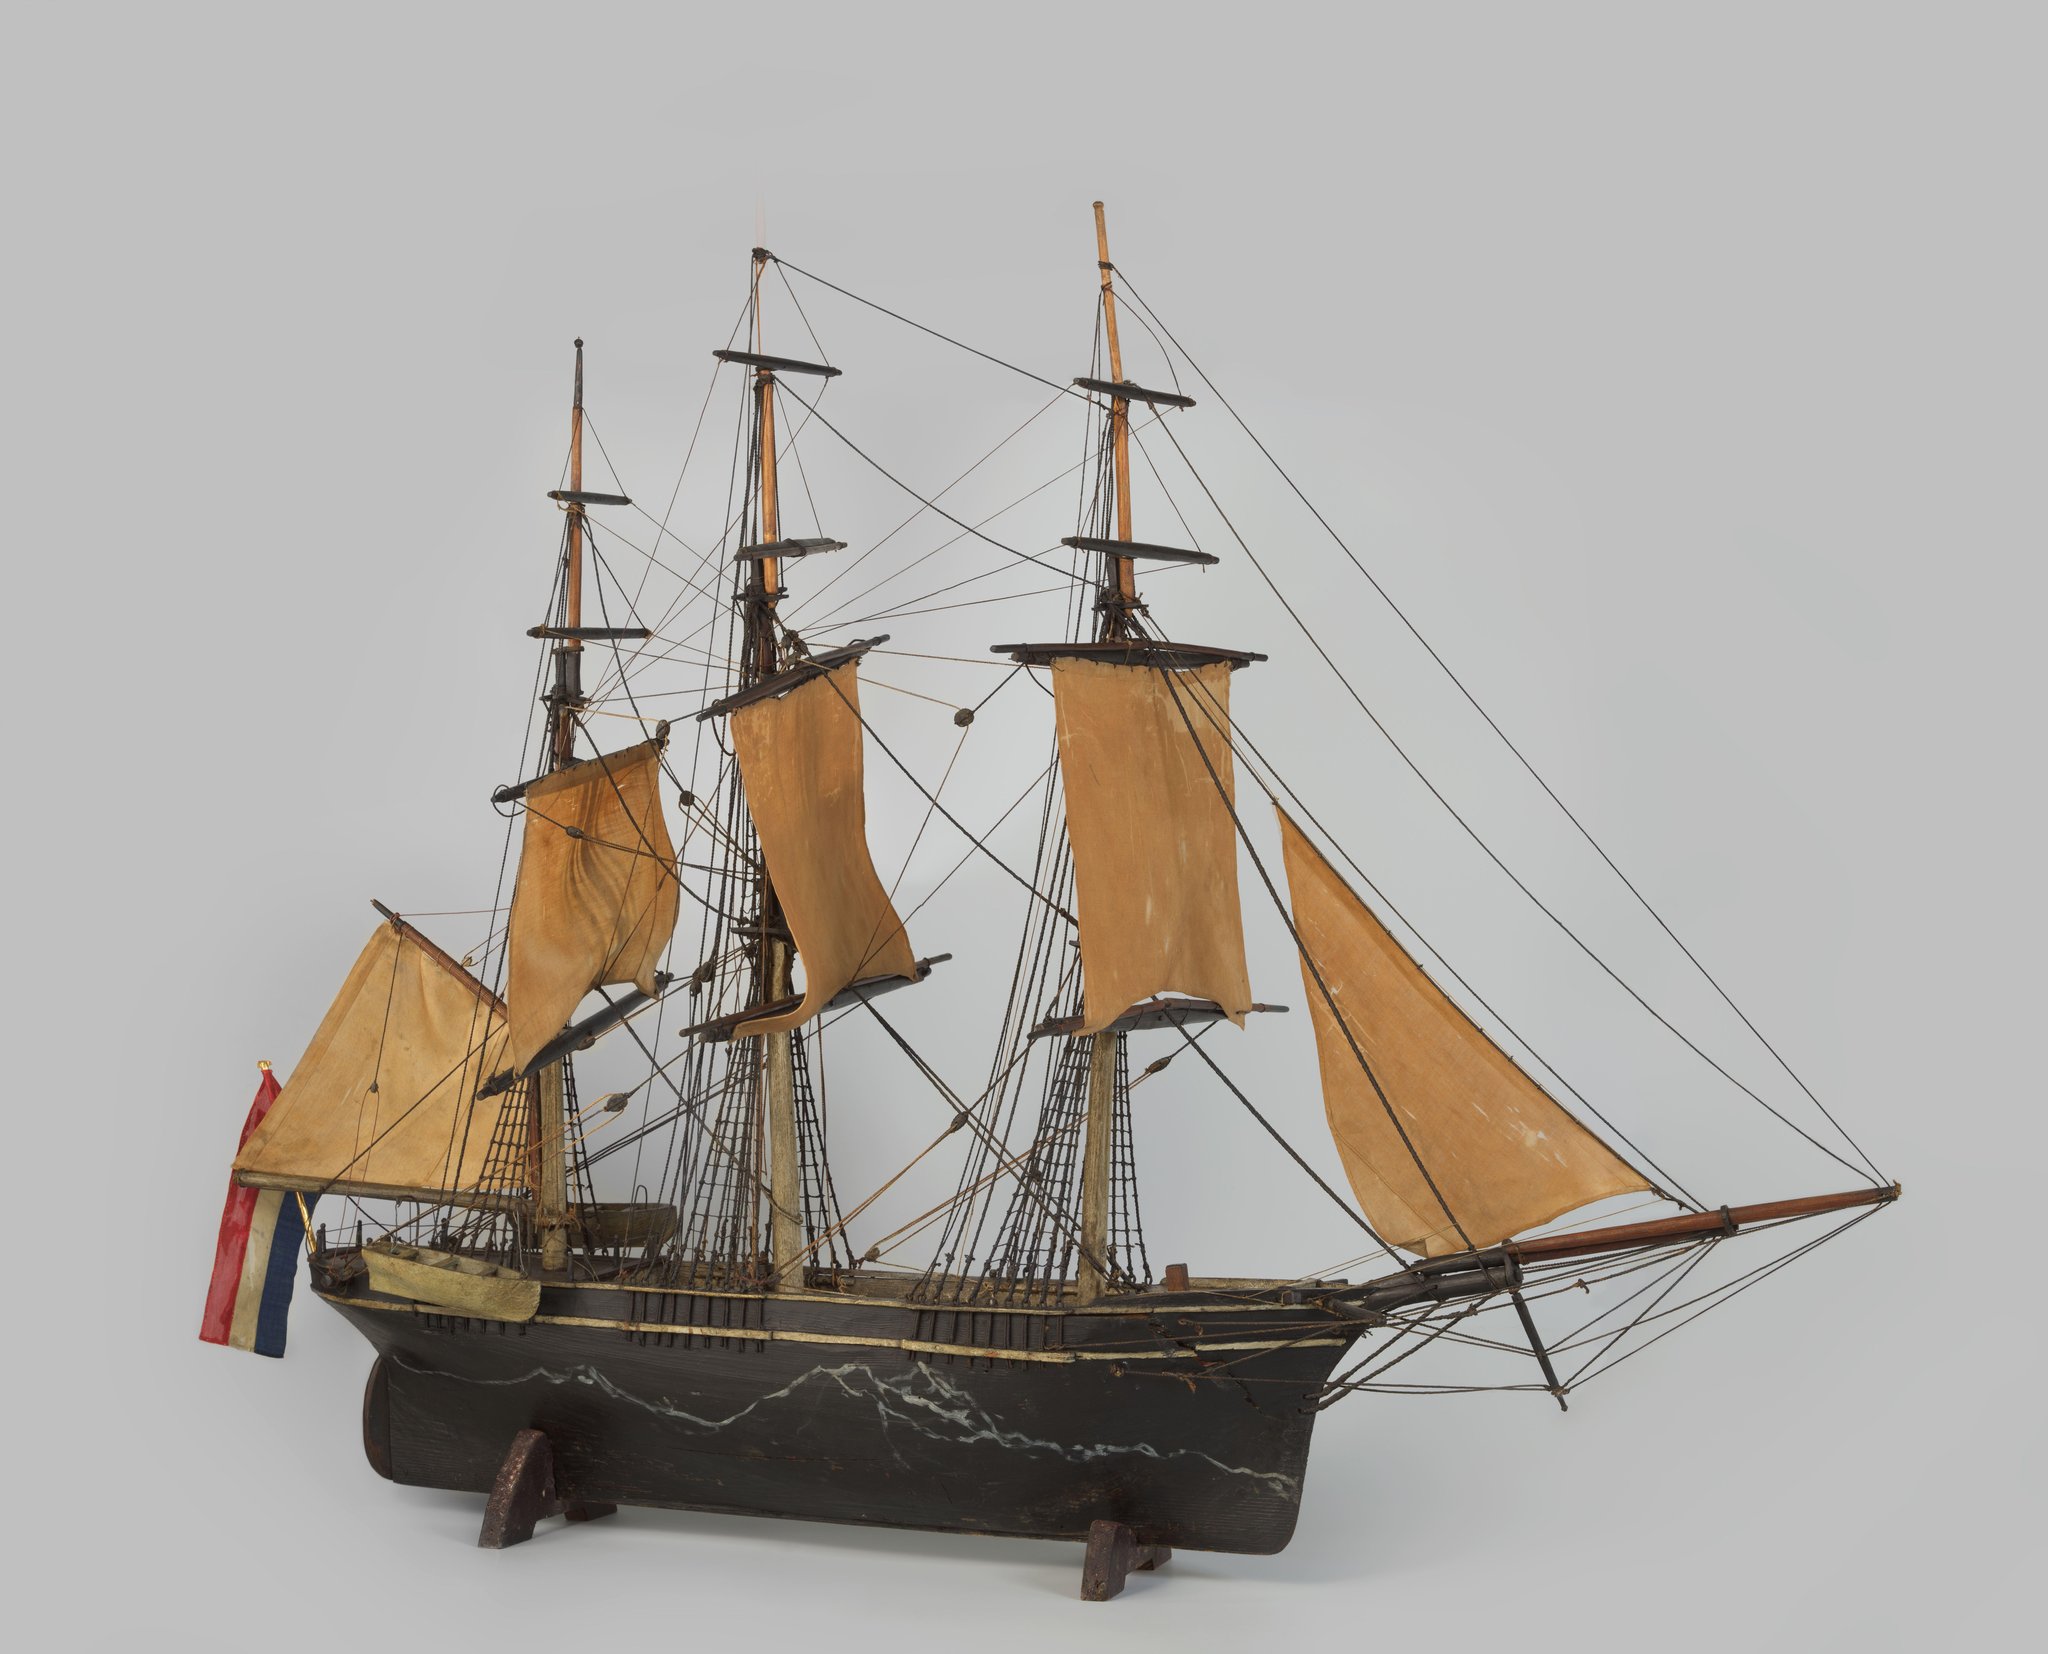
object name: ship model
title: Model of a Merchant Frigate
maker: Anonymous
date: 1850-1870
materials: fiber, textile, wood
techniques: polychromy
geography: netherlands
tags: ship-model (+ propulsion of vehicle, ship, etc. by wind)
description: Model van een fregatschip. Een deel van de zeilen is aanwezig, net als een Nederlandse vlag. Op de romp zijn golven getekend. Op standaard.